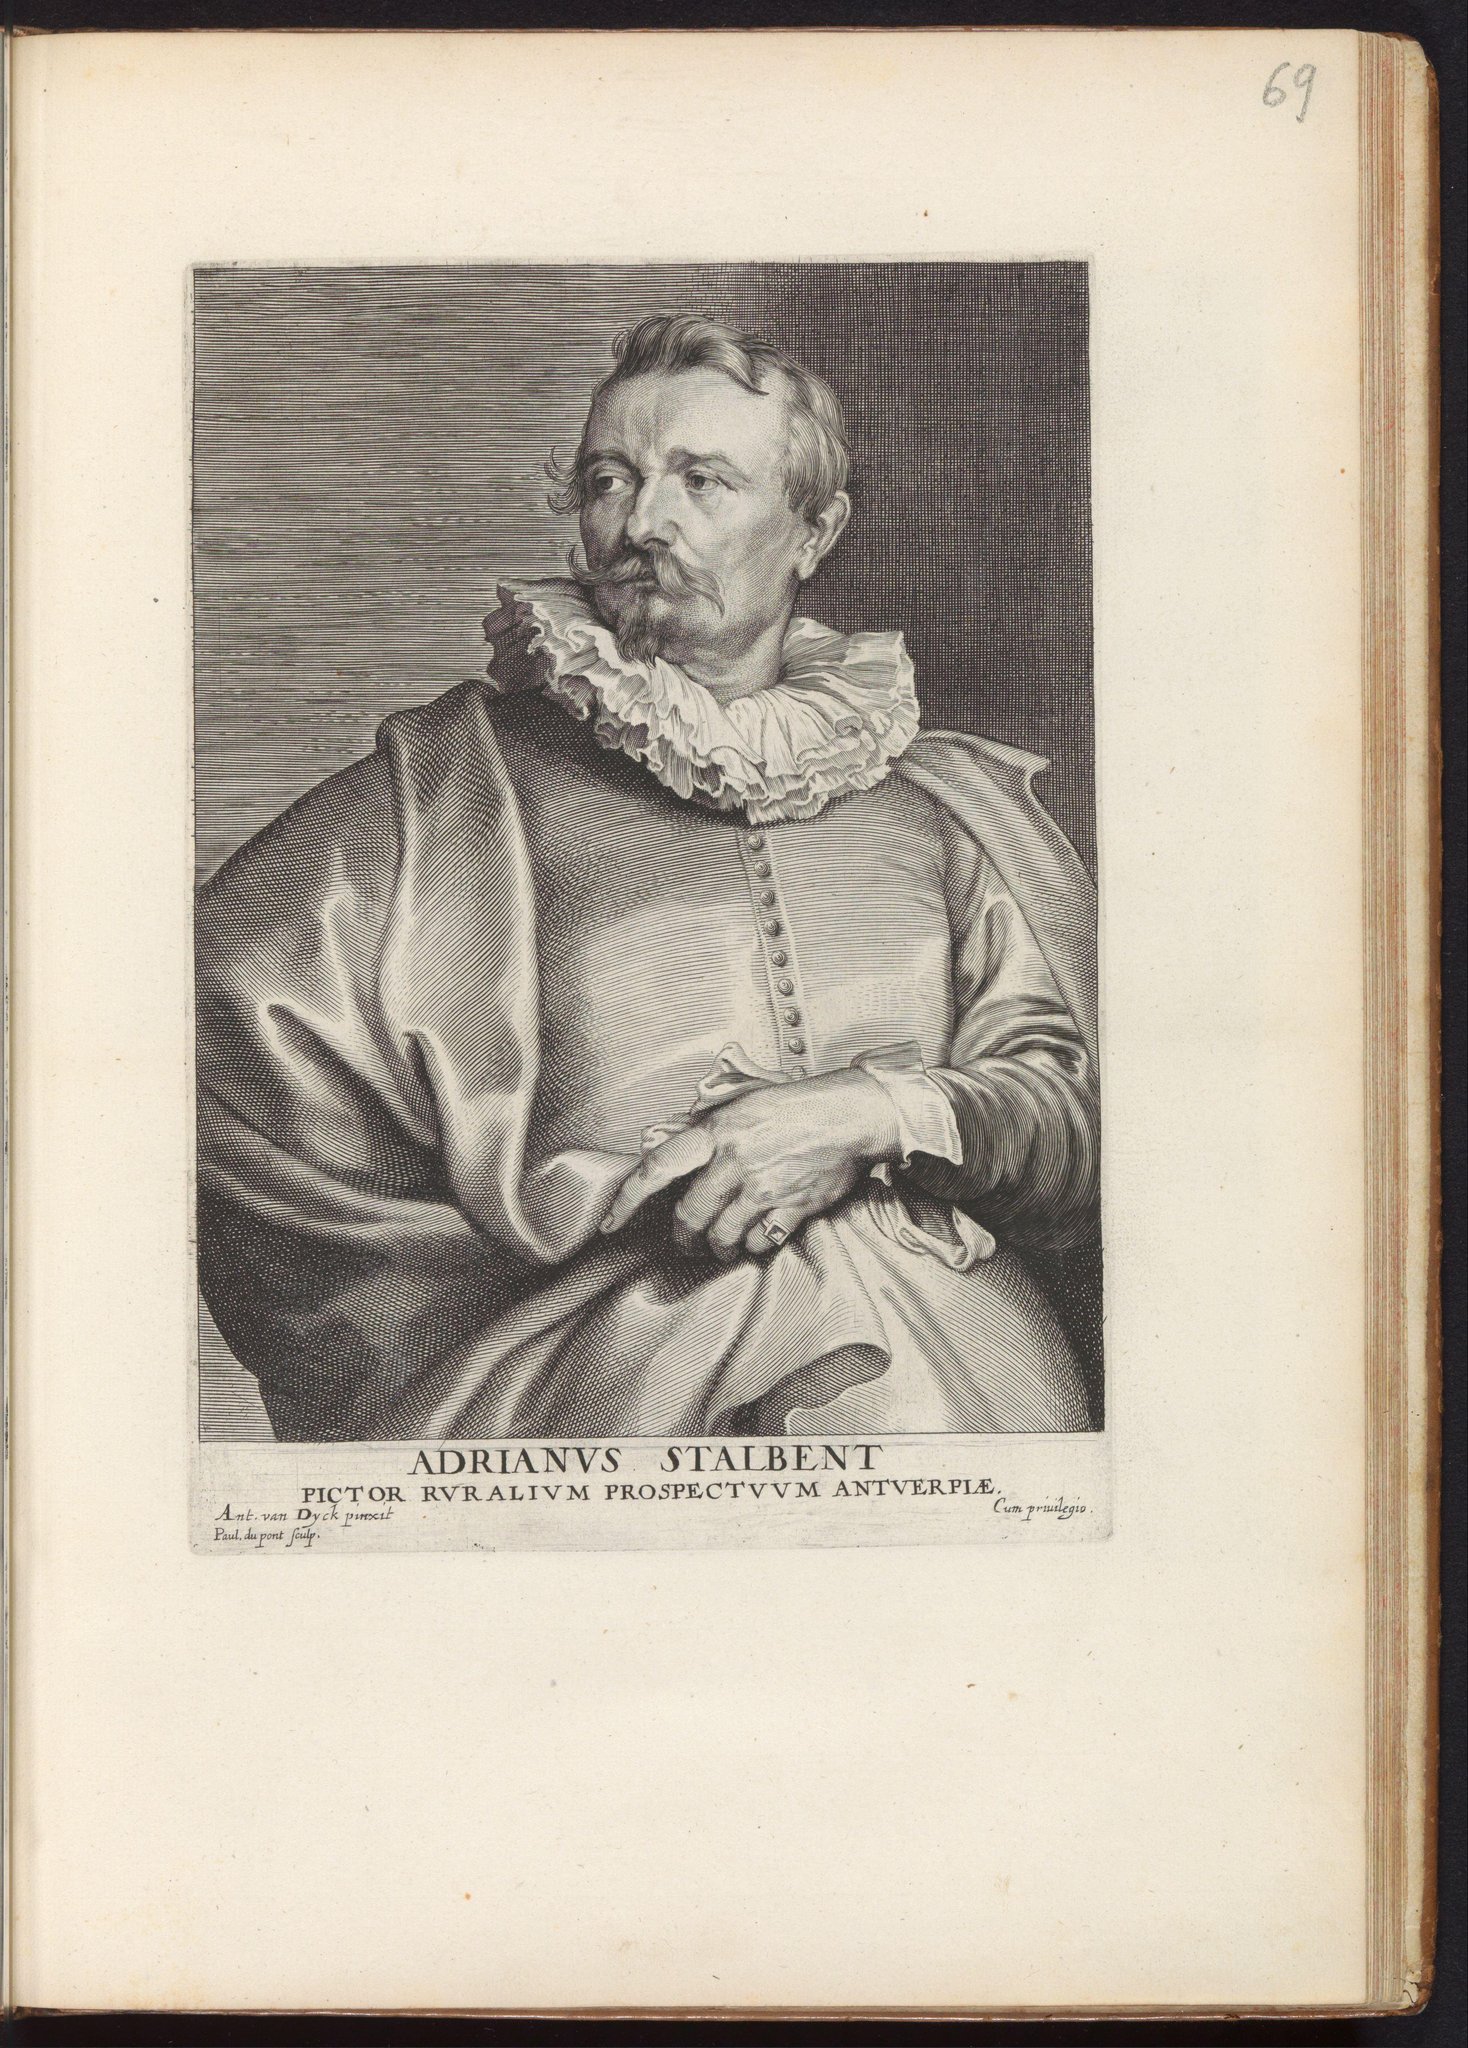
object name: album leaf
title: Iconographie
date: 1630-1641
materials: paper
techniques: engraving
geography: antwerp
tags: antwerp, painter, print maker, adriaen van stalbemt, portrait, self-portrait of painter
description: Deze prent maakt deel uit van een album.